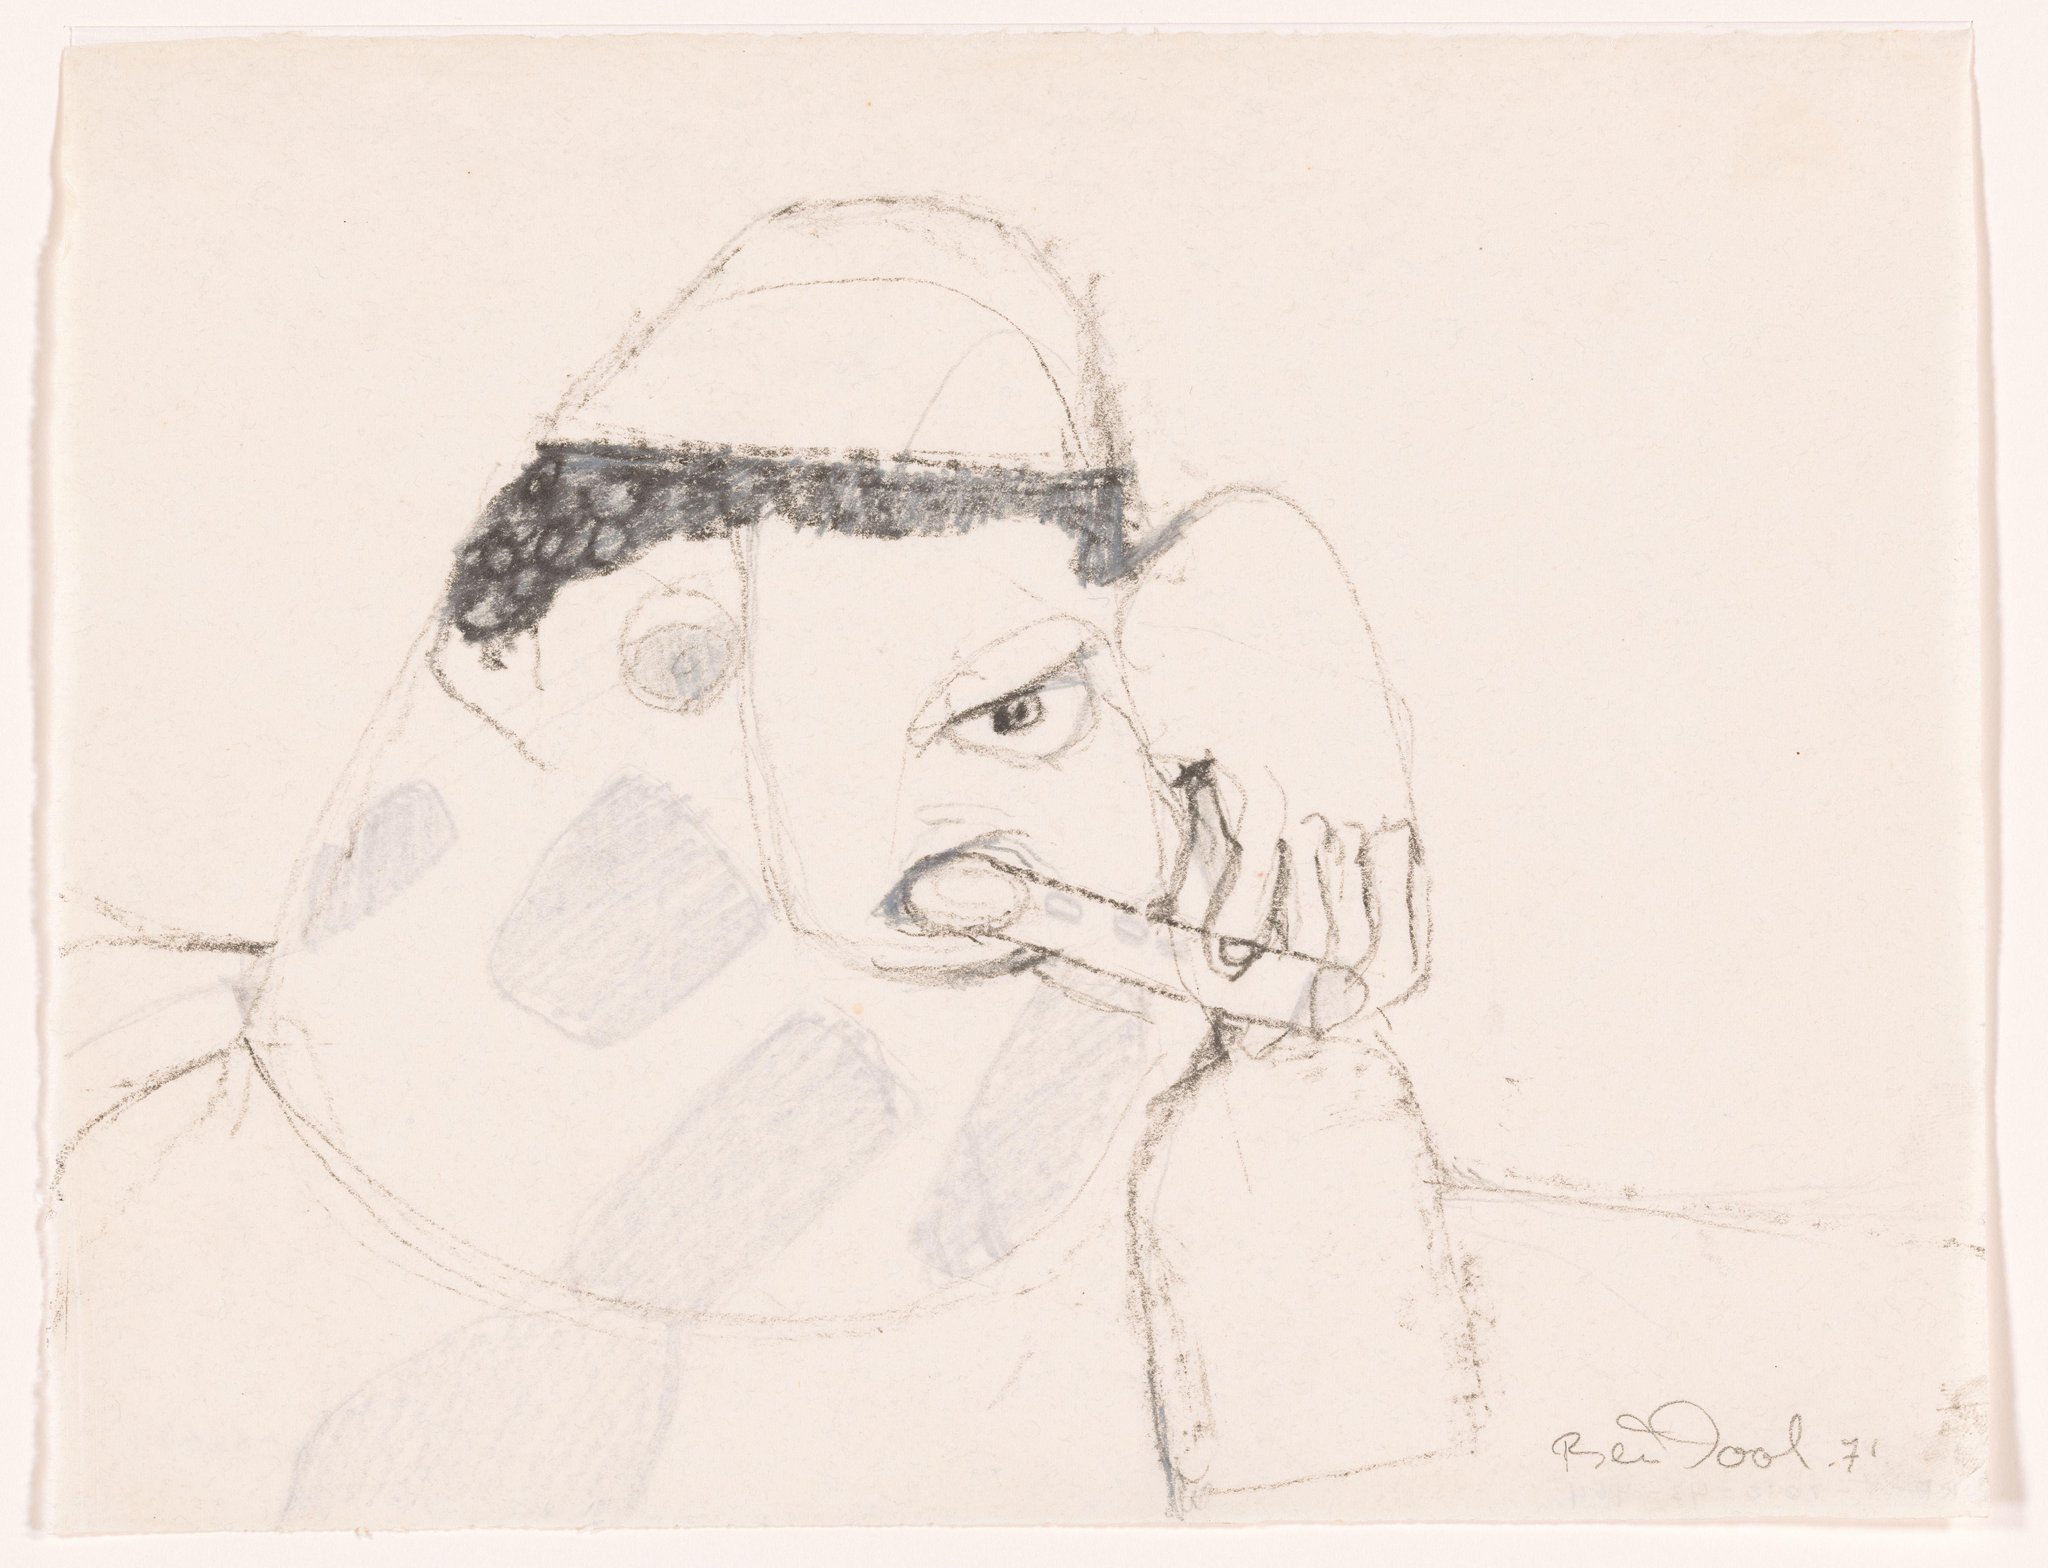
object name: drawing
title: Zonder titel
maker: rein dool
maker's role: draughtsman, painter, print maker, sculptor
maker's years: 1933-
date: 1971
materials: chalk, paper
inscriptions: signature and date: ‘Rein Dool 71’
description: Fluitspelende man, zijn hand ter hoogte van zijn oog.